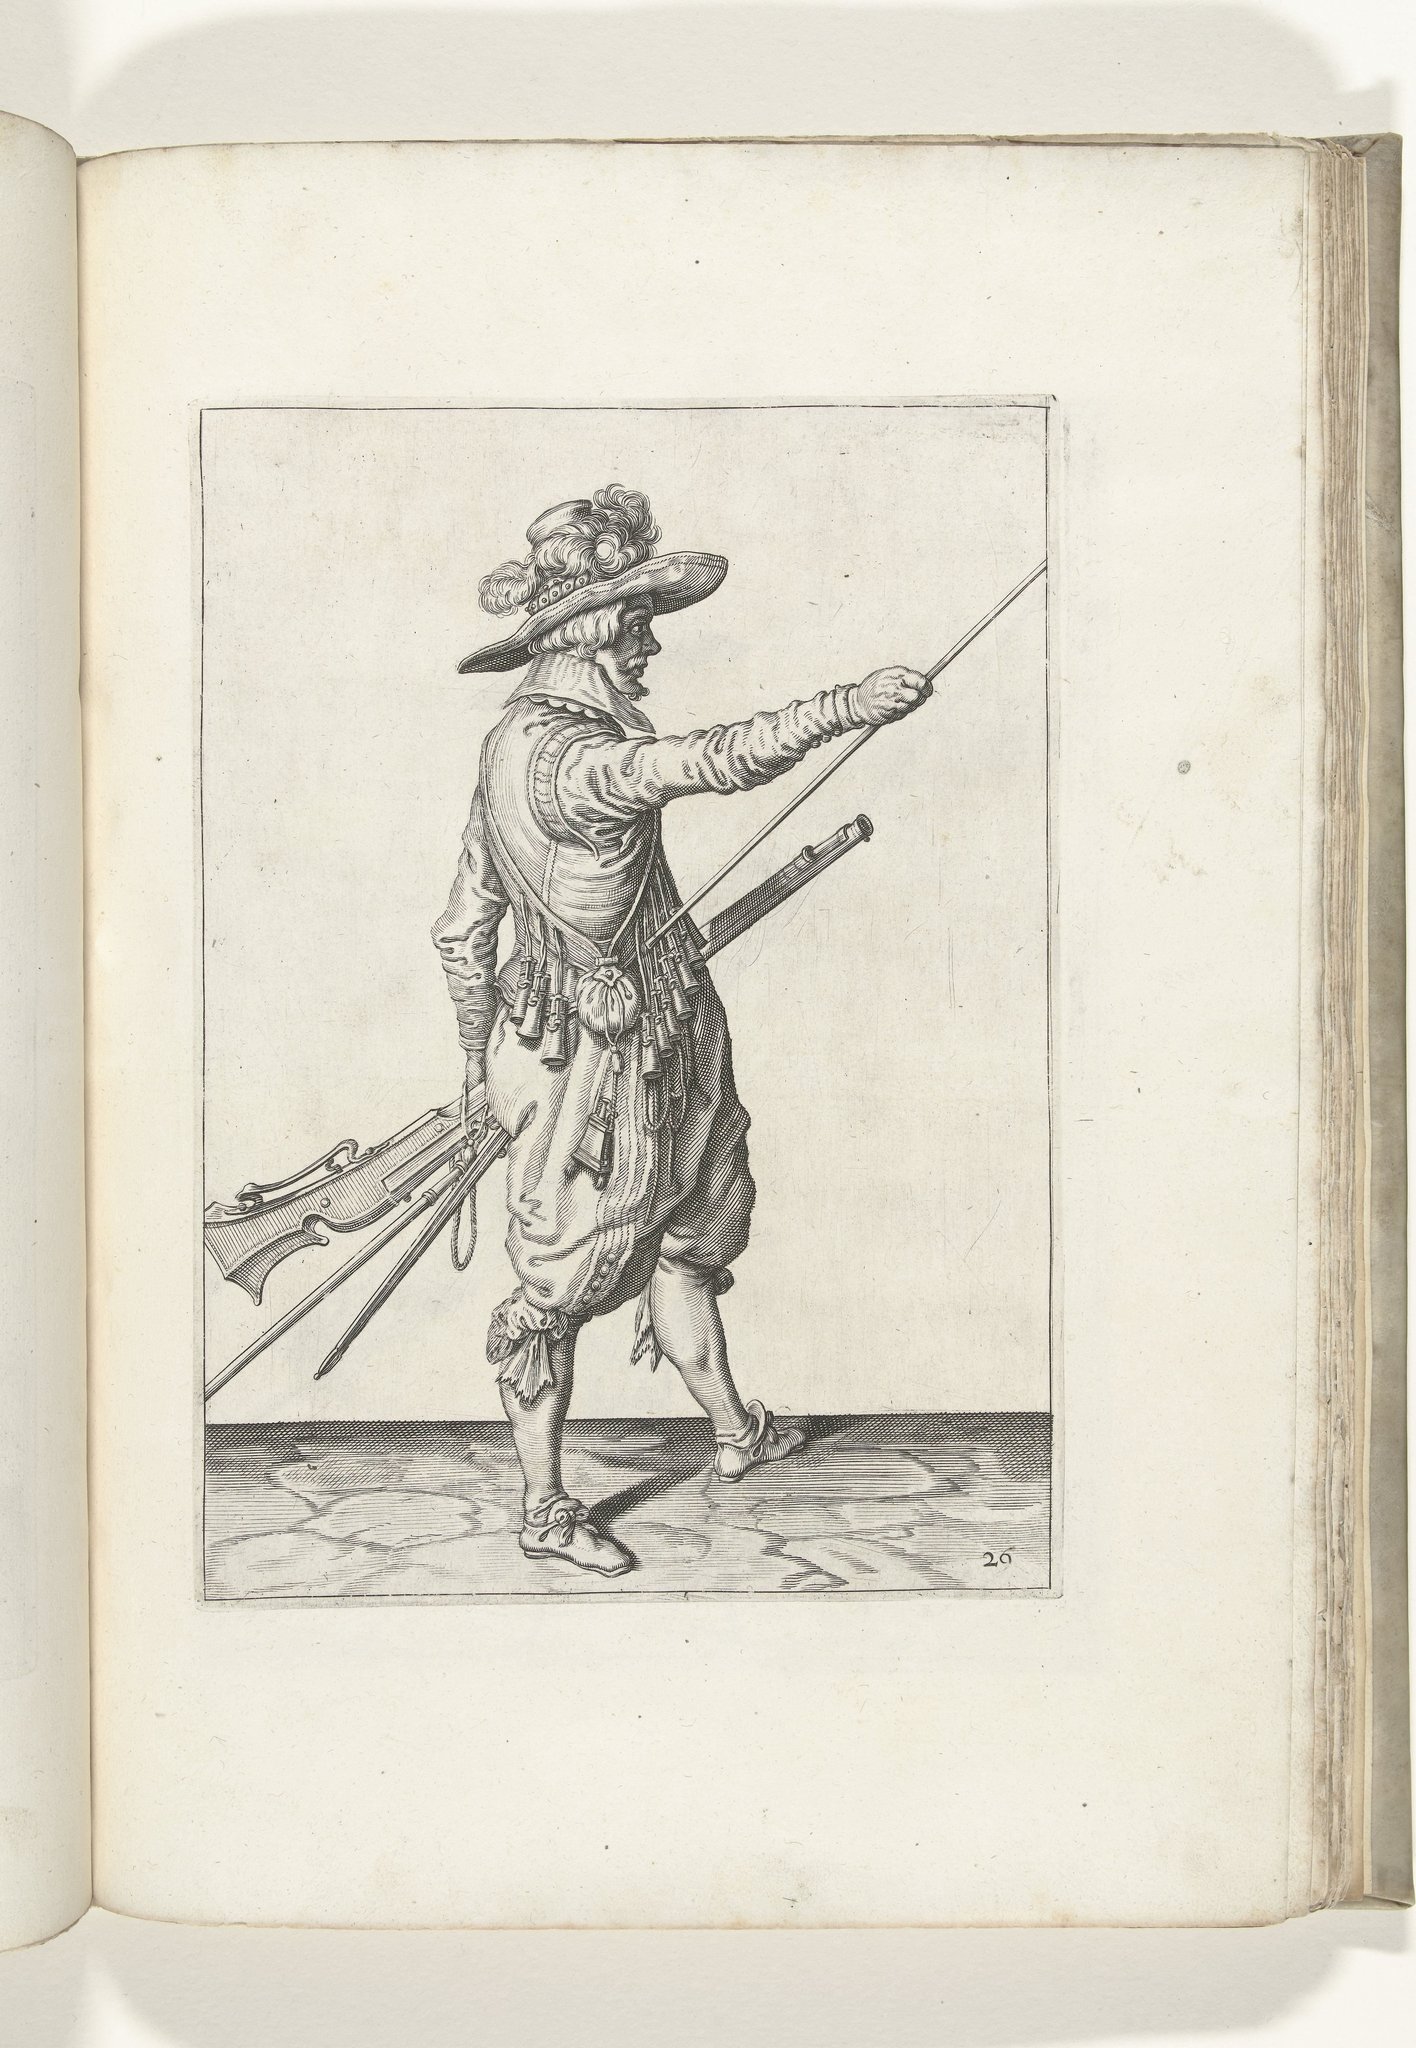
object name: print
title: Soldaat met een musket die zijn rechterhand naar het uiteinde van zijn laadstok schuift (nr. 26), ca. 1600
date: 1597-1607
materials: paper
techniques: engraving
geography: northern netherlands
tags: the hague, maurice (prince of orange), handling of weapons ~ military training, weapons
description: Een soldaat, ten voeten uit, naar rechts, die met zijn linkerhand bij zijn linkerdijbeen een musket (een bepaald type vuurwapen) vasthoudt en zijn rechterhand naar het uiteinde brengt van zijn laadstok, die hij tegen zijn rechterzij laat steunen (nr. 26), ca. 1600. In zijn linkerhand behalve het musket ook een lont; aan zijn linkerpols een furket (musketvork). Plaat 26 in de instructies voor het hanteren van het musket: Corte onderrechtinghe op de figuerliicke afbeeldinghe, soo veel aengaet het recht ghebruyck vant Musquet. Onderdeel van de illustraties in: J. de Gheyn, Wapenhandelinghe van Roers Musquetten ende spiessen, 's-Gravenhage, 1607. Krijgswezen rond 1600.